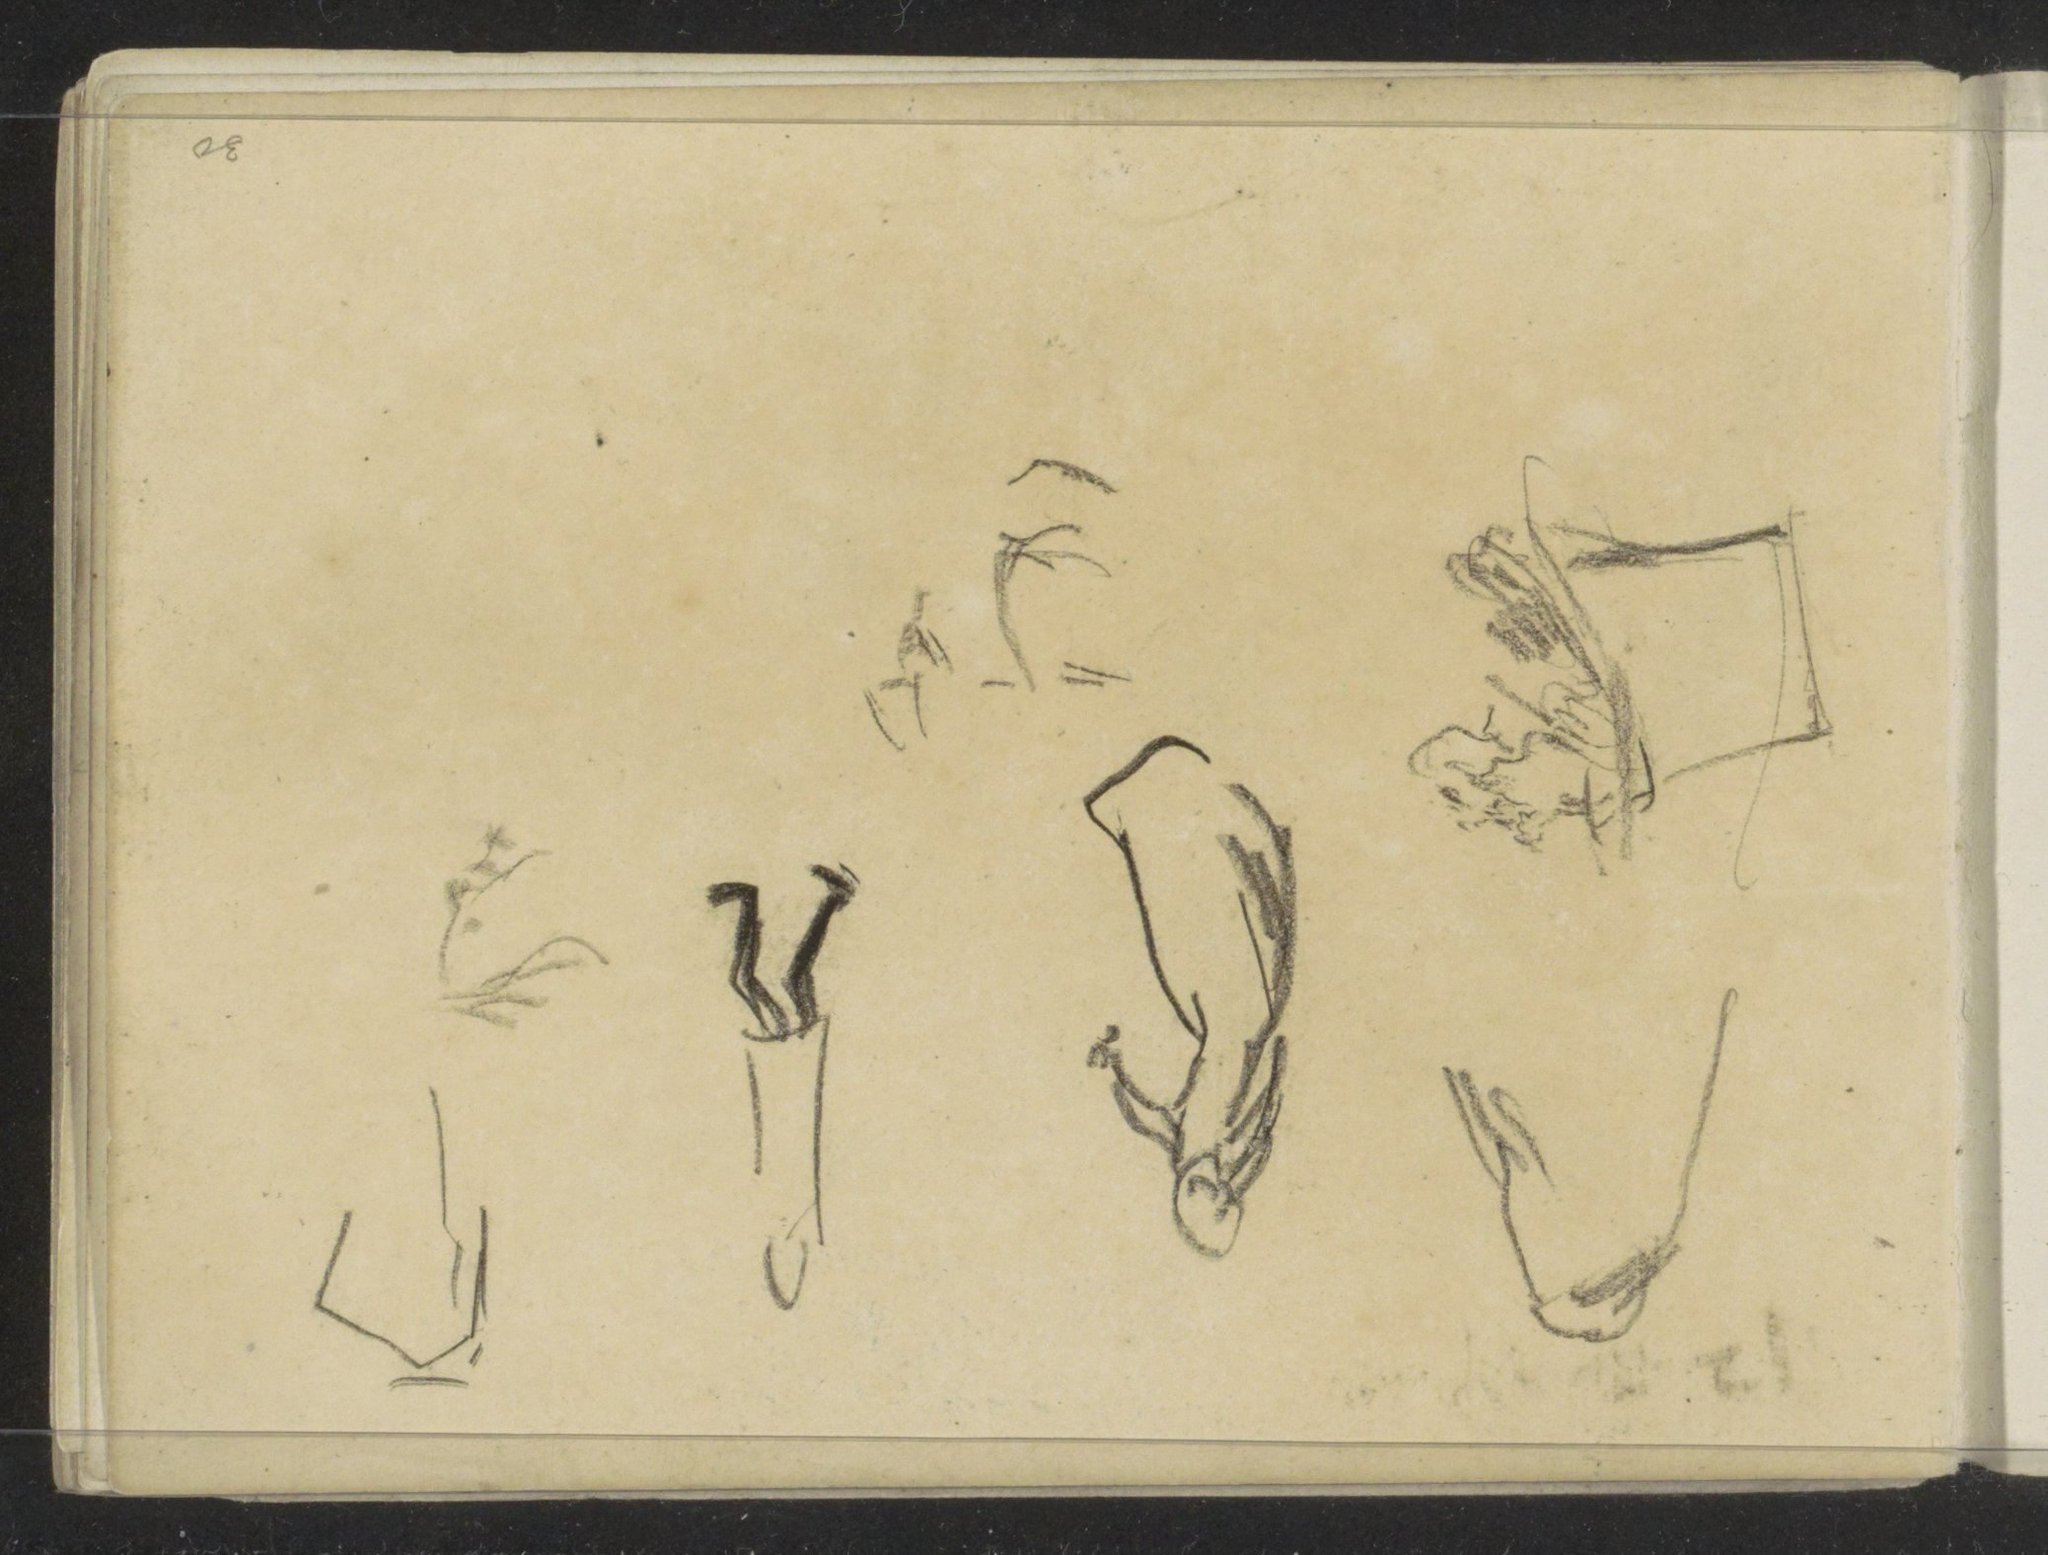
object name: sketchbook leaf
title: Figuurstudies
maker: isaac israels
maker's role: draughtsman, painter, print maker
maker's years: 1865-1934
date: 1886-1934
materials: chalk, paper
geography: amsterdam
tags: standing figure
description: Blad 29 verso uit schetsboek LXIV met 29 bladen.